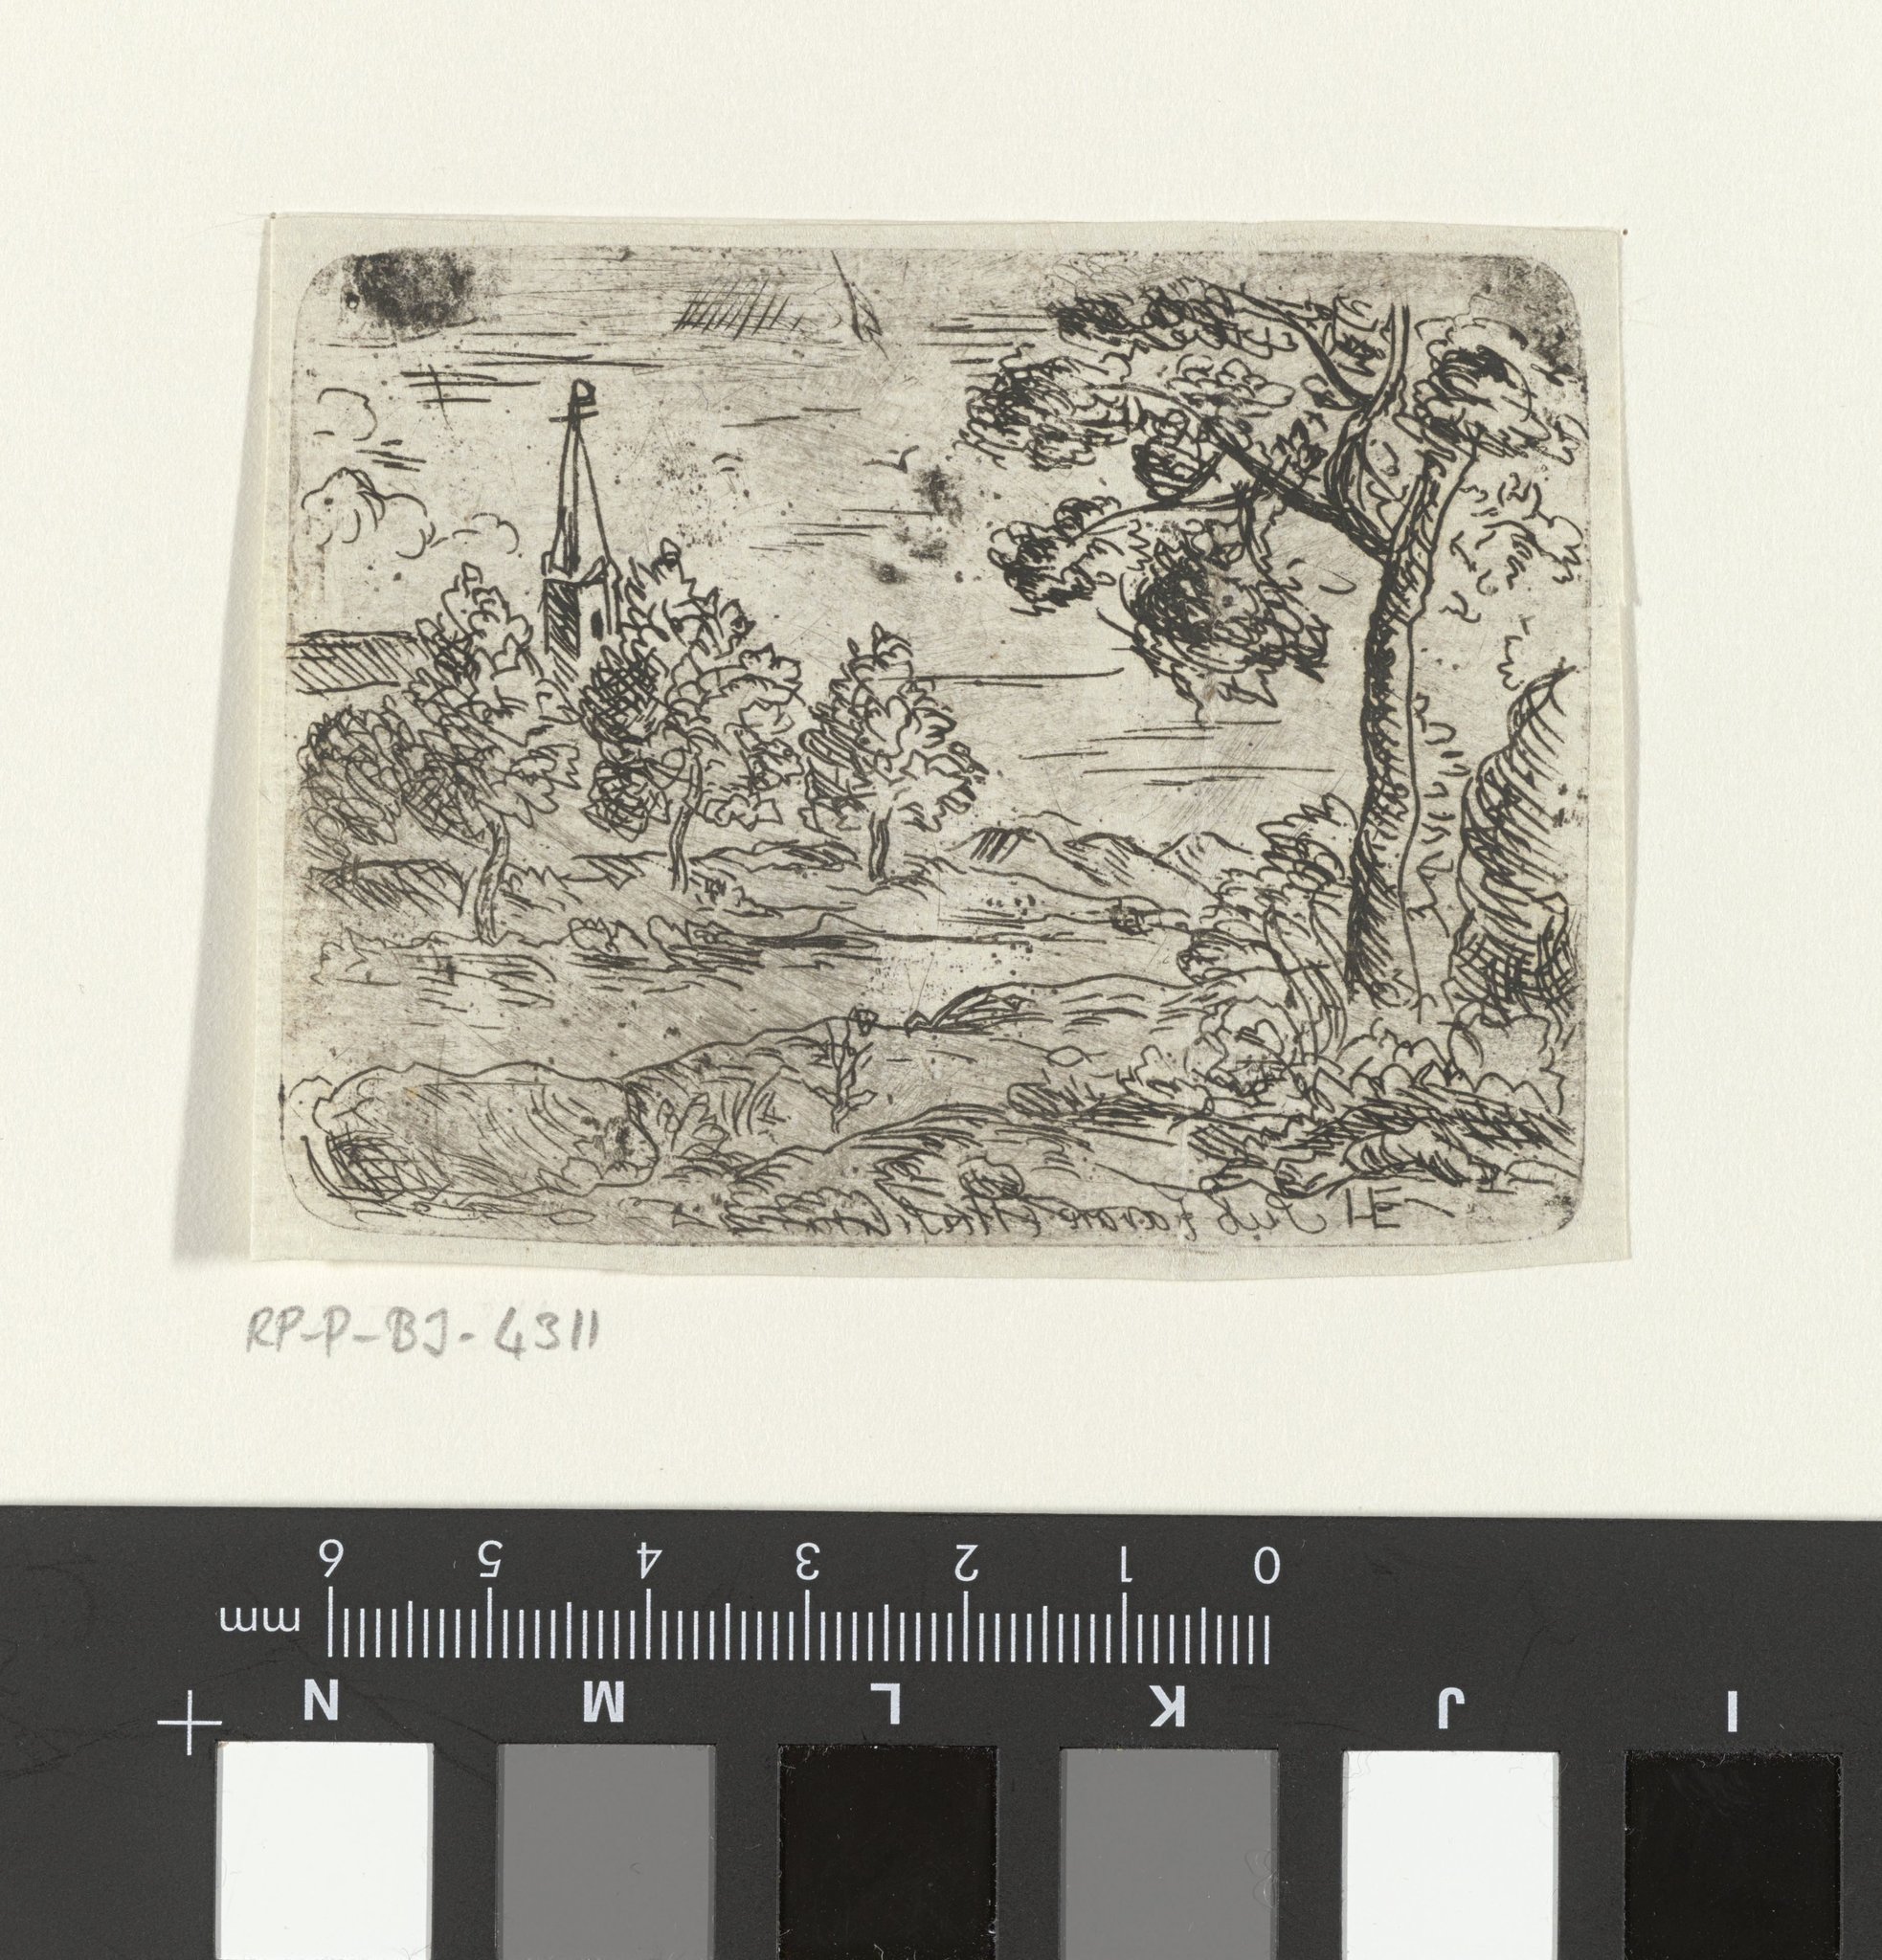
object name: print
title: Landschap met kerk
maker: abraham corneille de brakonier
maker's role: print maker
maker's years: 1724-1770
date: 1760-1770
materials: paper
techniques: etching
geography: netherlands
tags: landscapes in the temperate zone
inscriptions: collector's mark: Lugt 2228